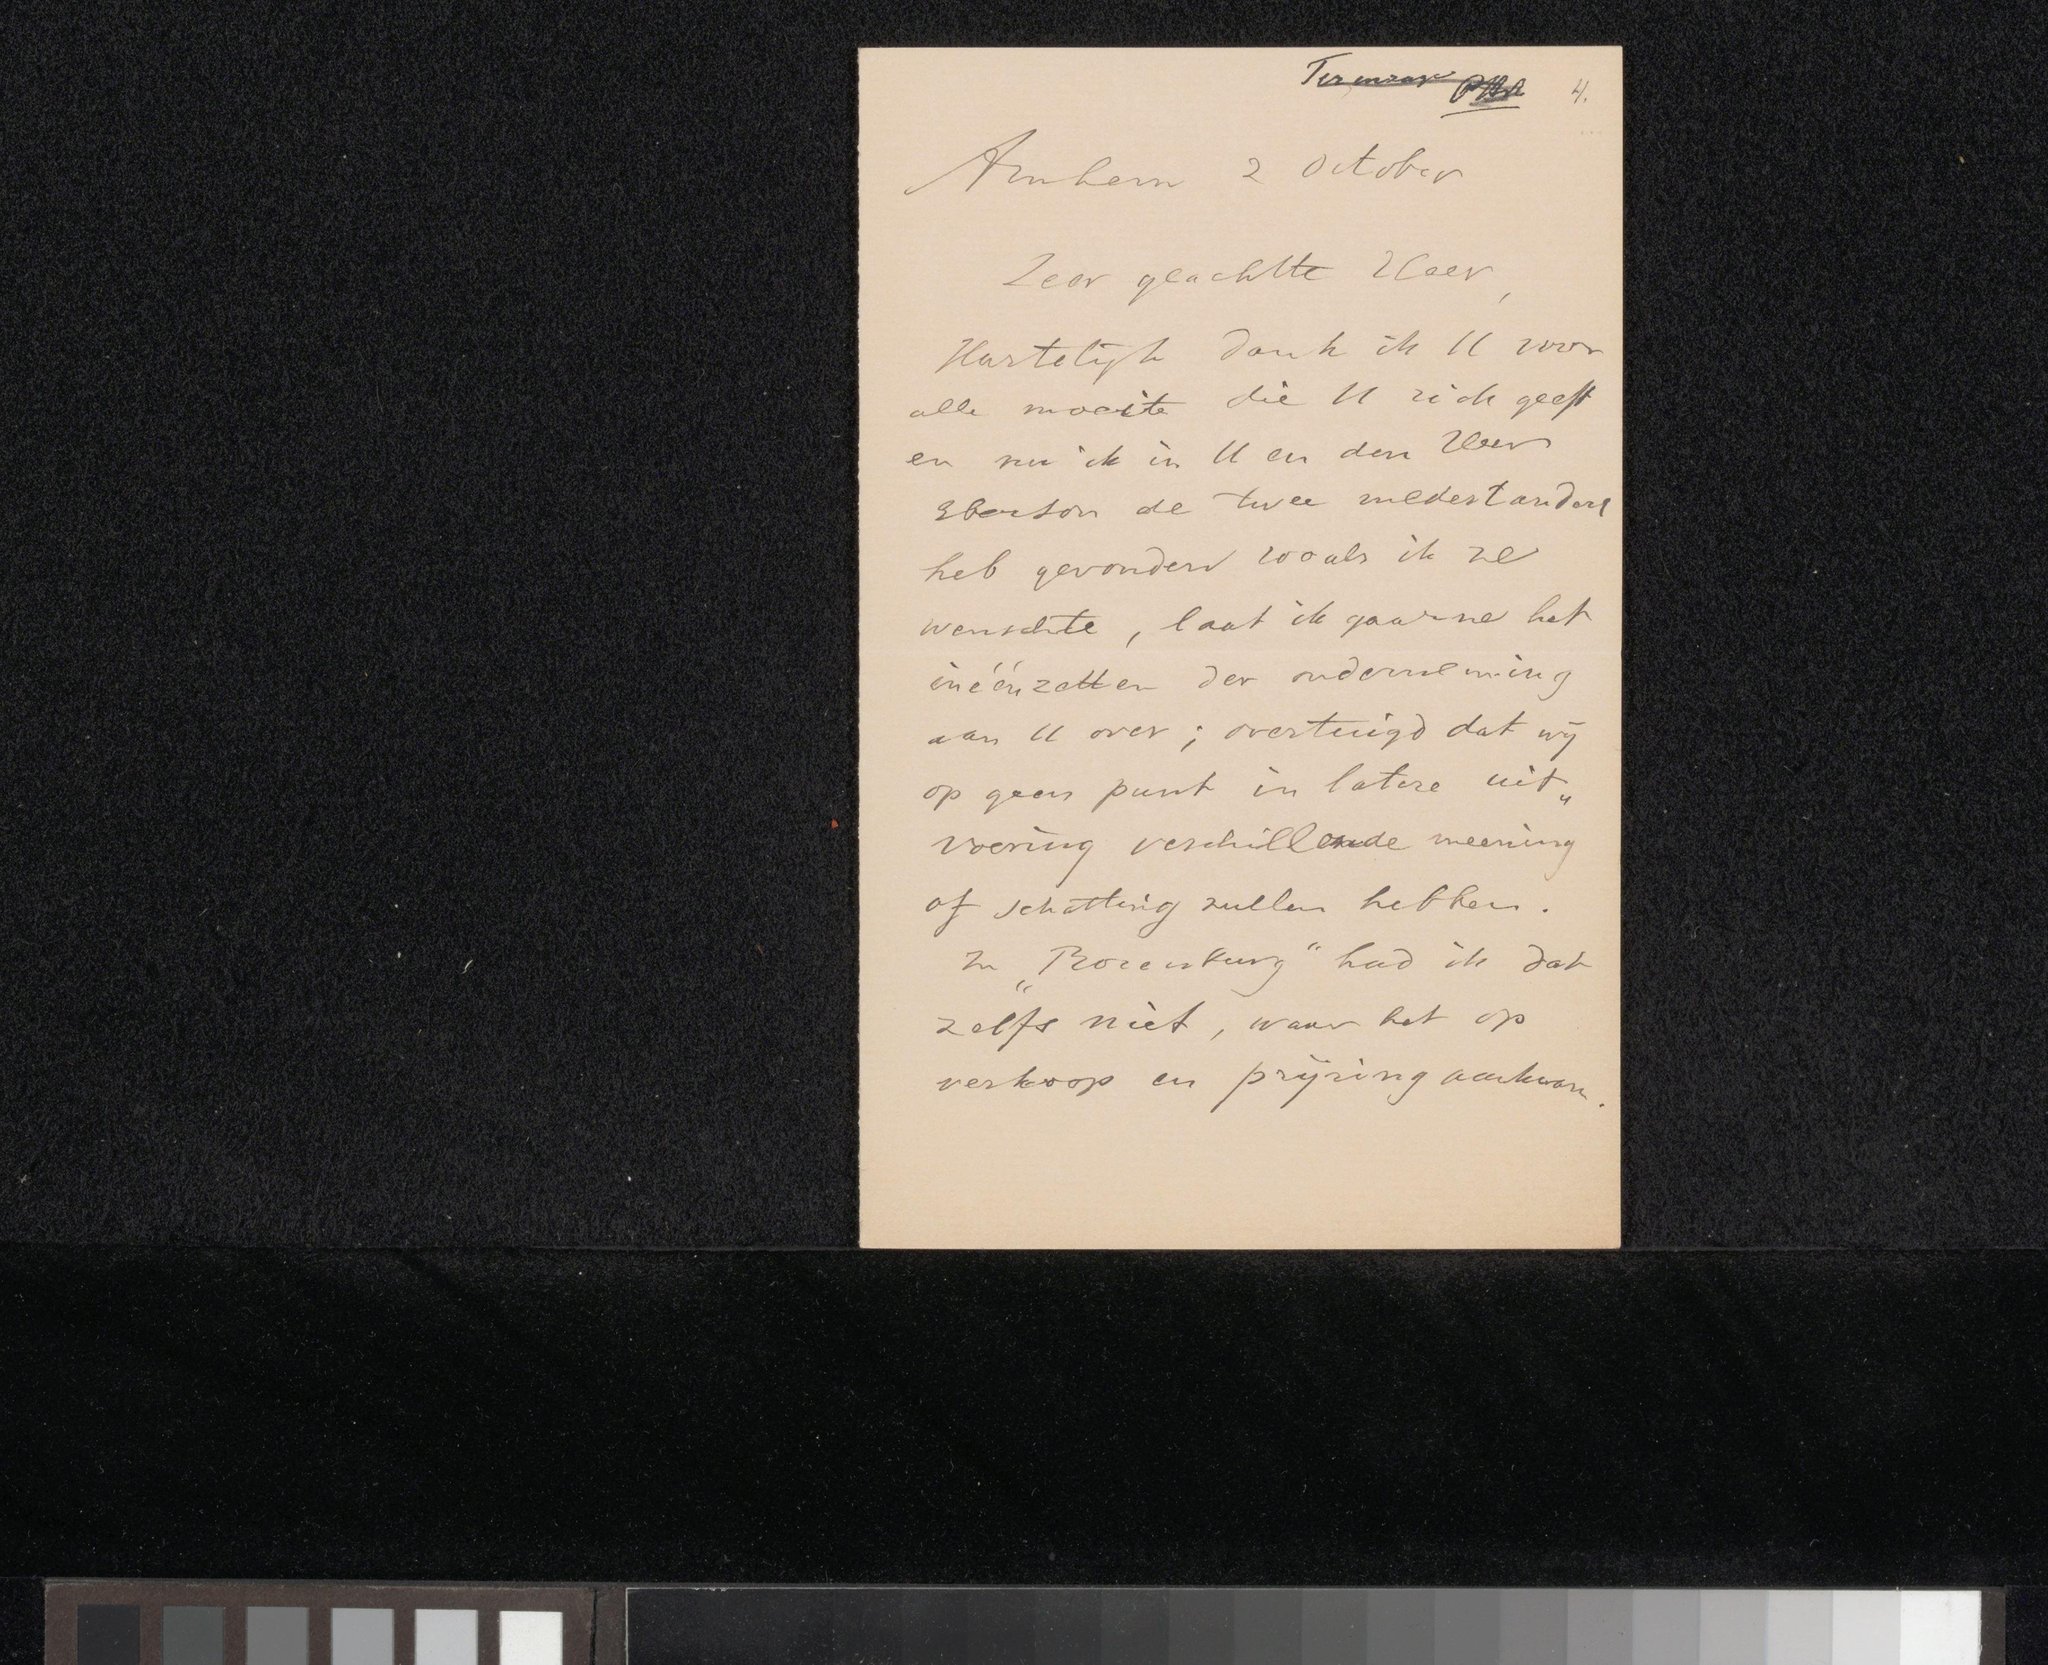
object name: letter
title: Brief aan Pieter Haverkorn van Rijsewijk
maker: theo colenbrander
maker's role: draughtsman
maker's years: 1841-1930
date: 1851-1915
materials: ink, paper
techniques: pen, writing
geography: arnhem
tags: w.g. eberson, pieter haverkorn van rijsewijk, money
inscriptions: collector's mark: ‘RPK’, watermark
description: RP-D-COLENBRANDER-4A en RP-D-COLENBRANDER-4B vormen een doorlopende brief.